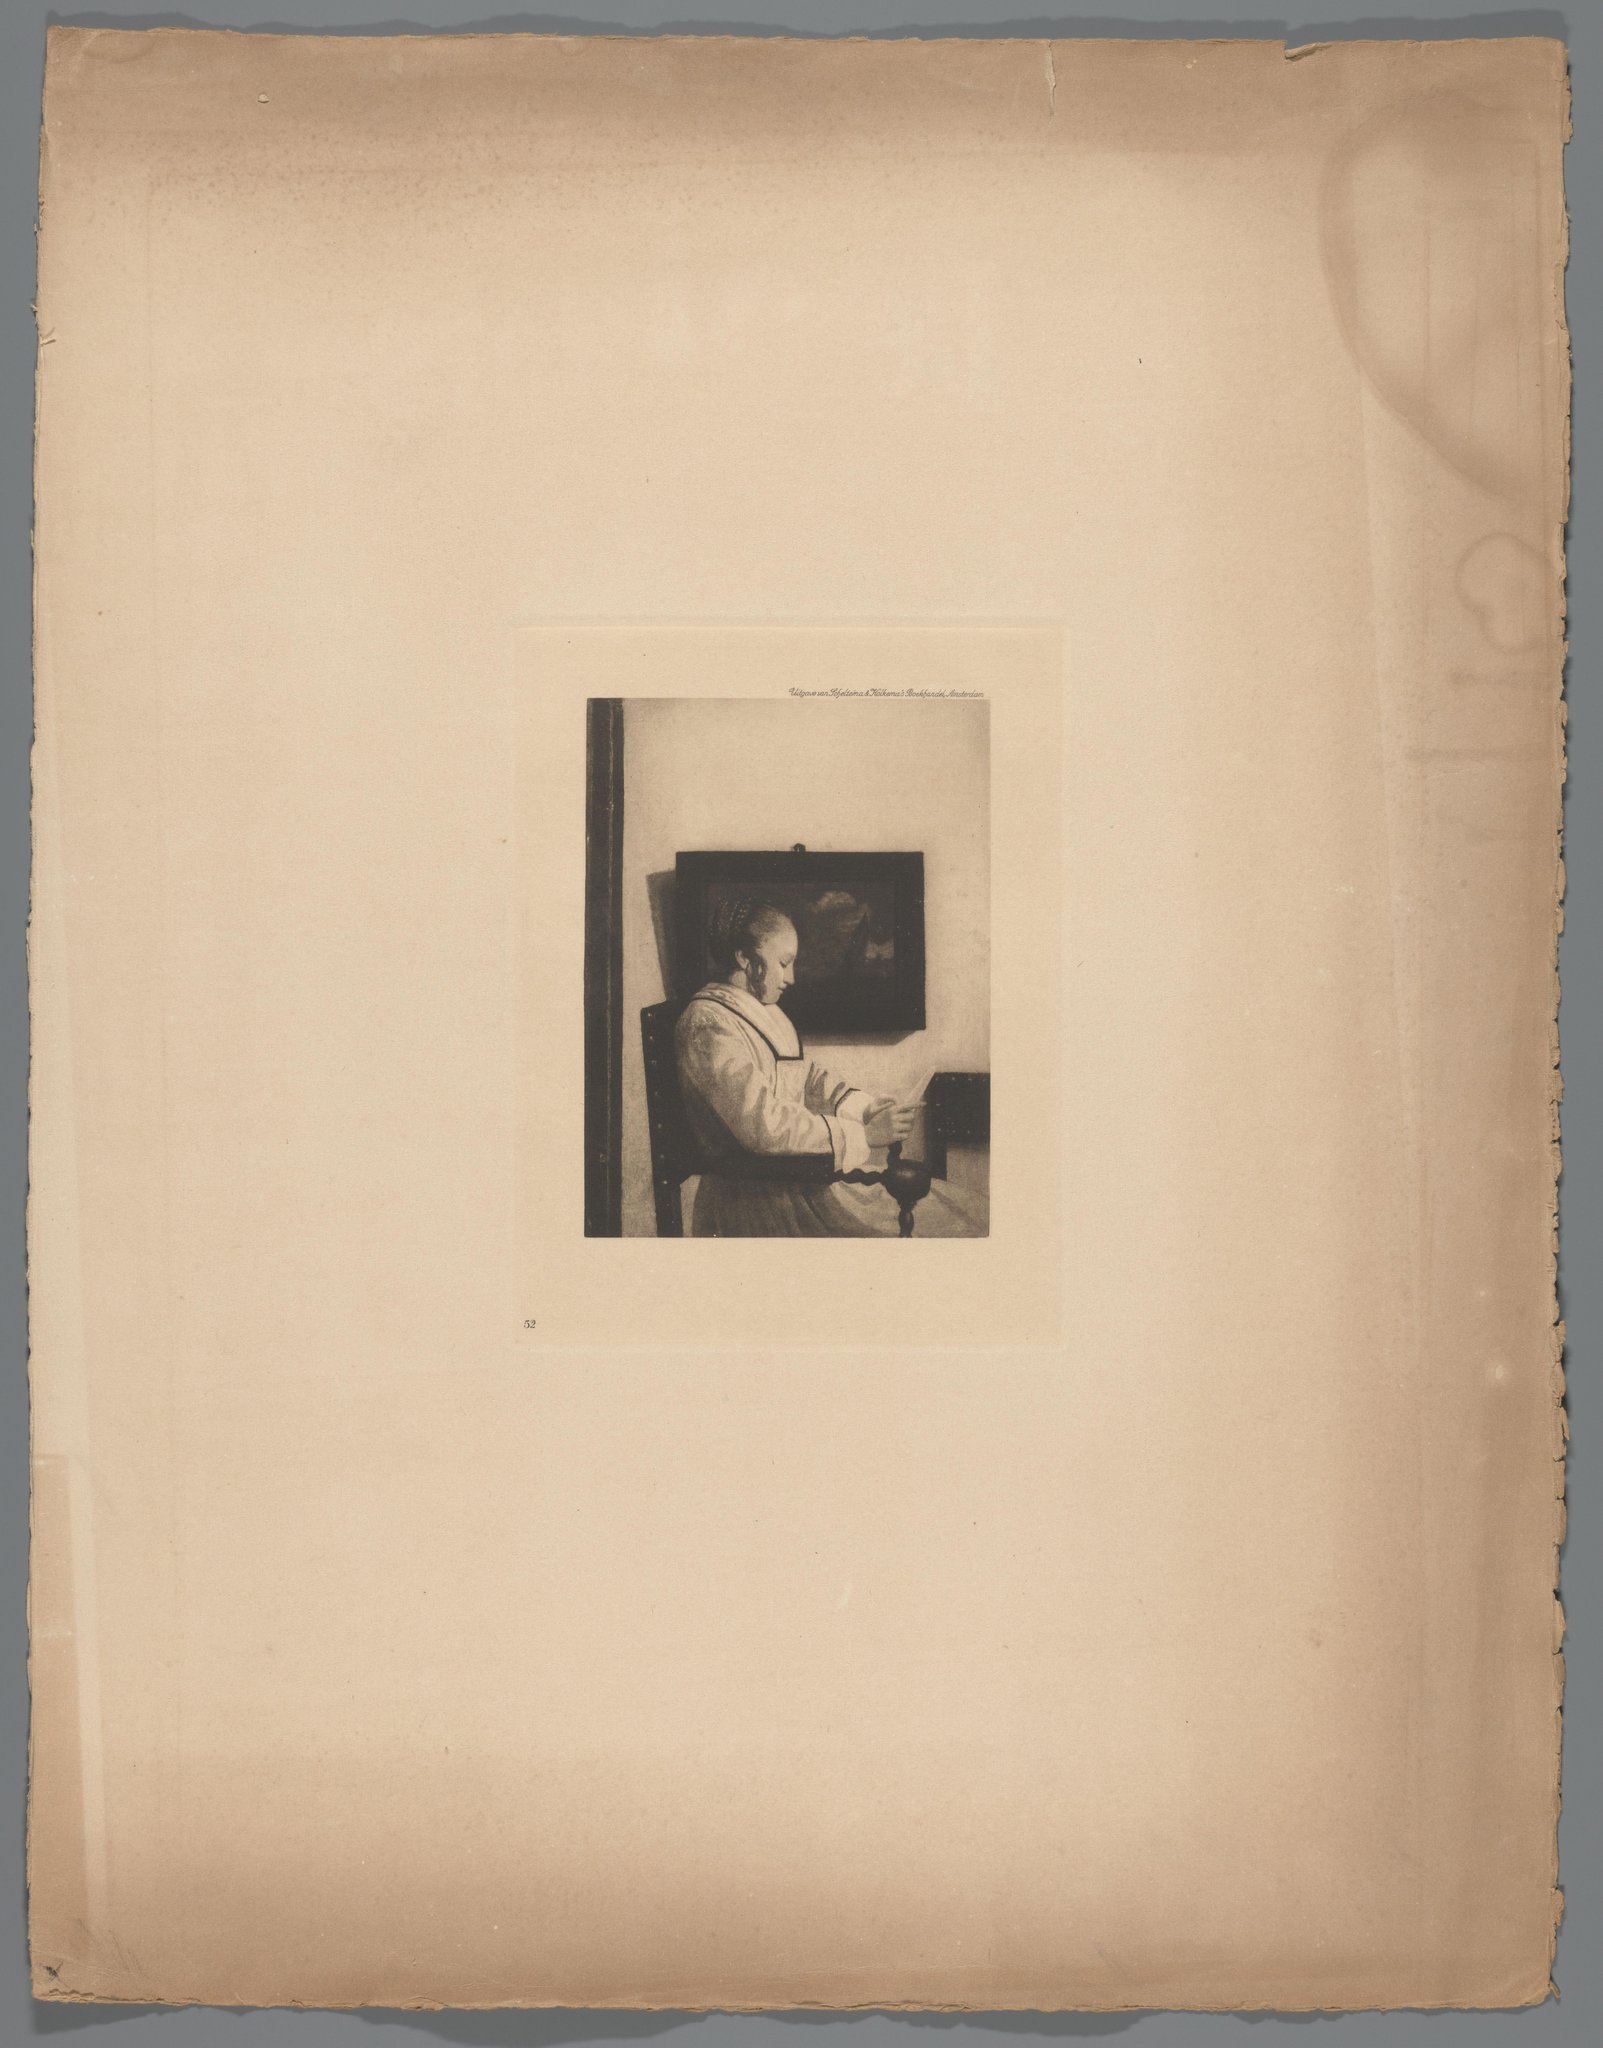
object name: photomechanical print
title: Reproductie van het schilderij Een jonge vrouw die leest door een imitator van Johannes Vermeer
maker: Anonymous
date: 1880-2023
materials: paper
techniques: photoaquatint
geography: amsterdam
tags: adolescent, young woman, maiden, reading, anonymous historical person portrayed alone - bb - woman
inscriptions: inscription: ‘Uitgave van Scheltema & Holkema's Boekhandel, Amsterdam/ 52’